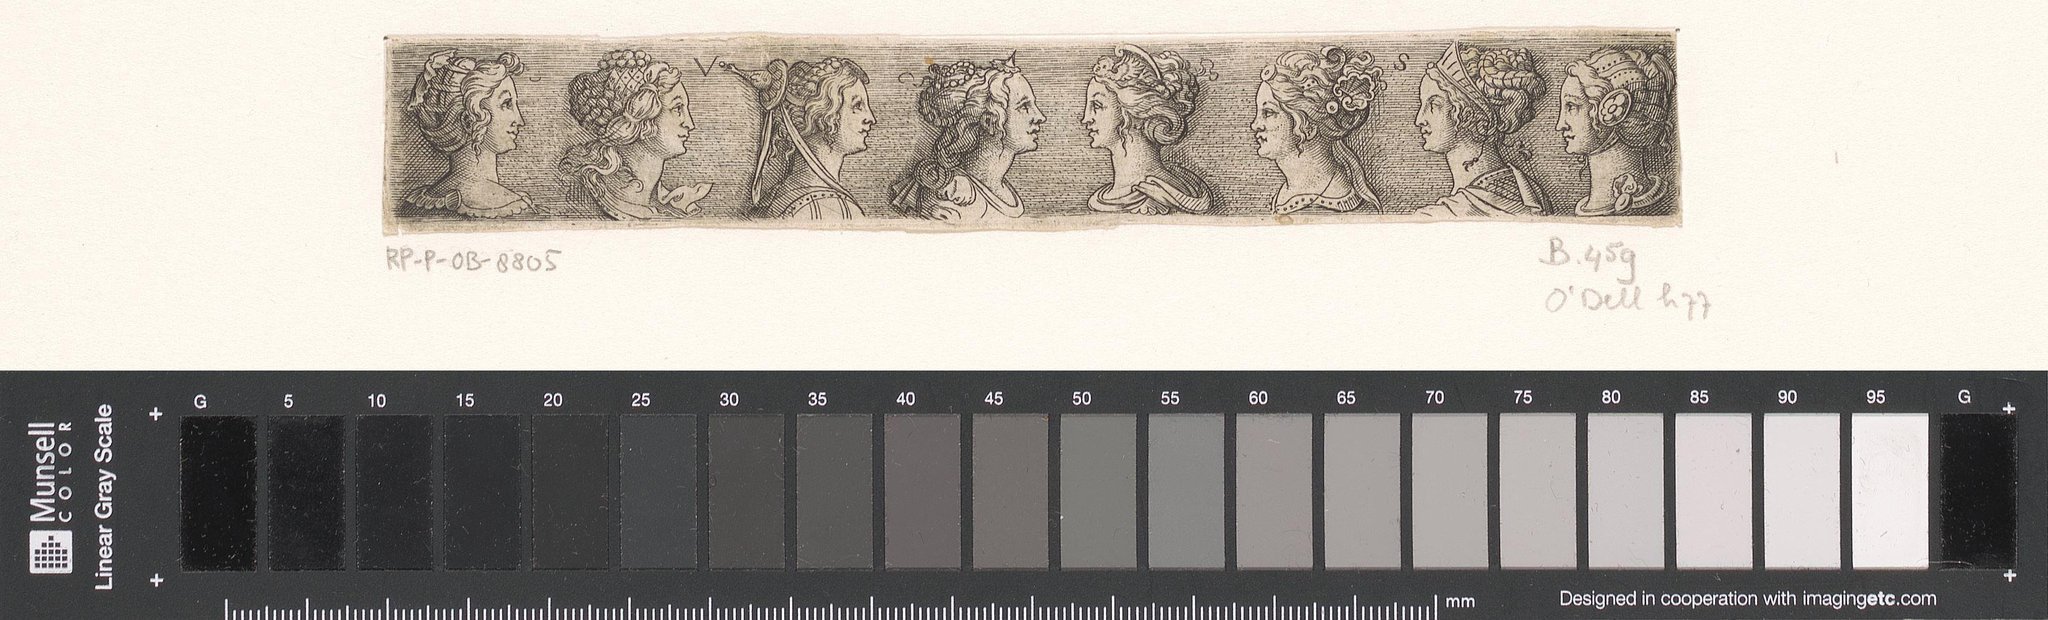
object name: print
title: Fries met acht bustes van vrouwen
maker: virgilius solis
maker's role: draughtsman, print maker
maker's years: 1514-1562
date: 1524-1562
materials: paper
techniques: engraving, etching, intaglio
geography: nuremberg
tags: adult woman, head-gear, hairdress - aa - ~ women, chest, bust - aa - female human figure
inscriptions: collector's mark: Lugt 2228, number: ‘10’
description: Acht bustes van vrouwen, en profil. De linker vier bustes zijn naar rechts gericht en de rechts vier naar links.